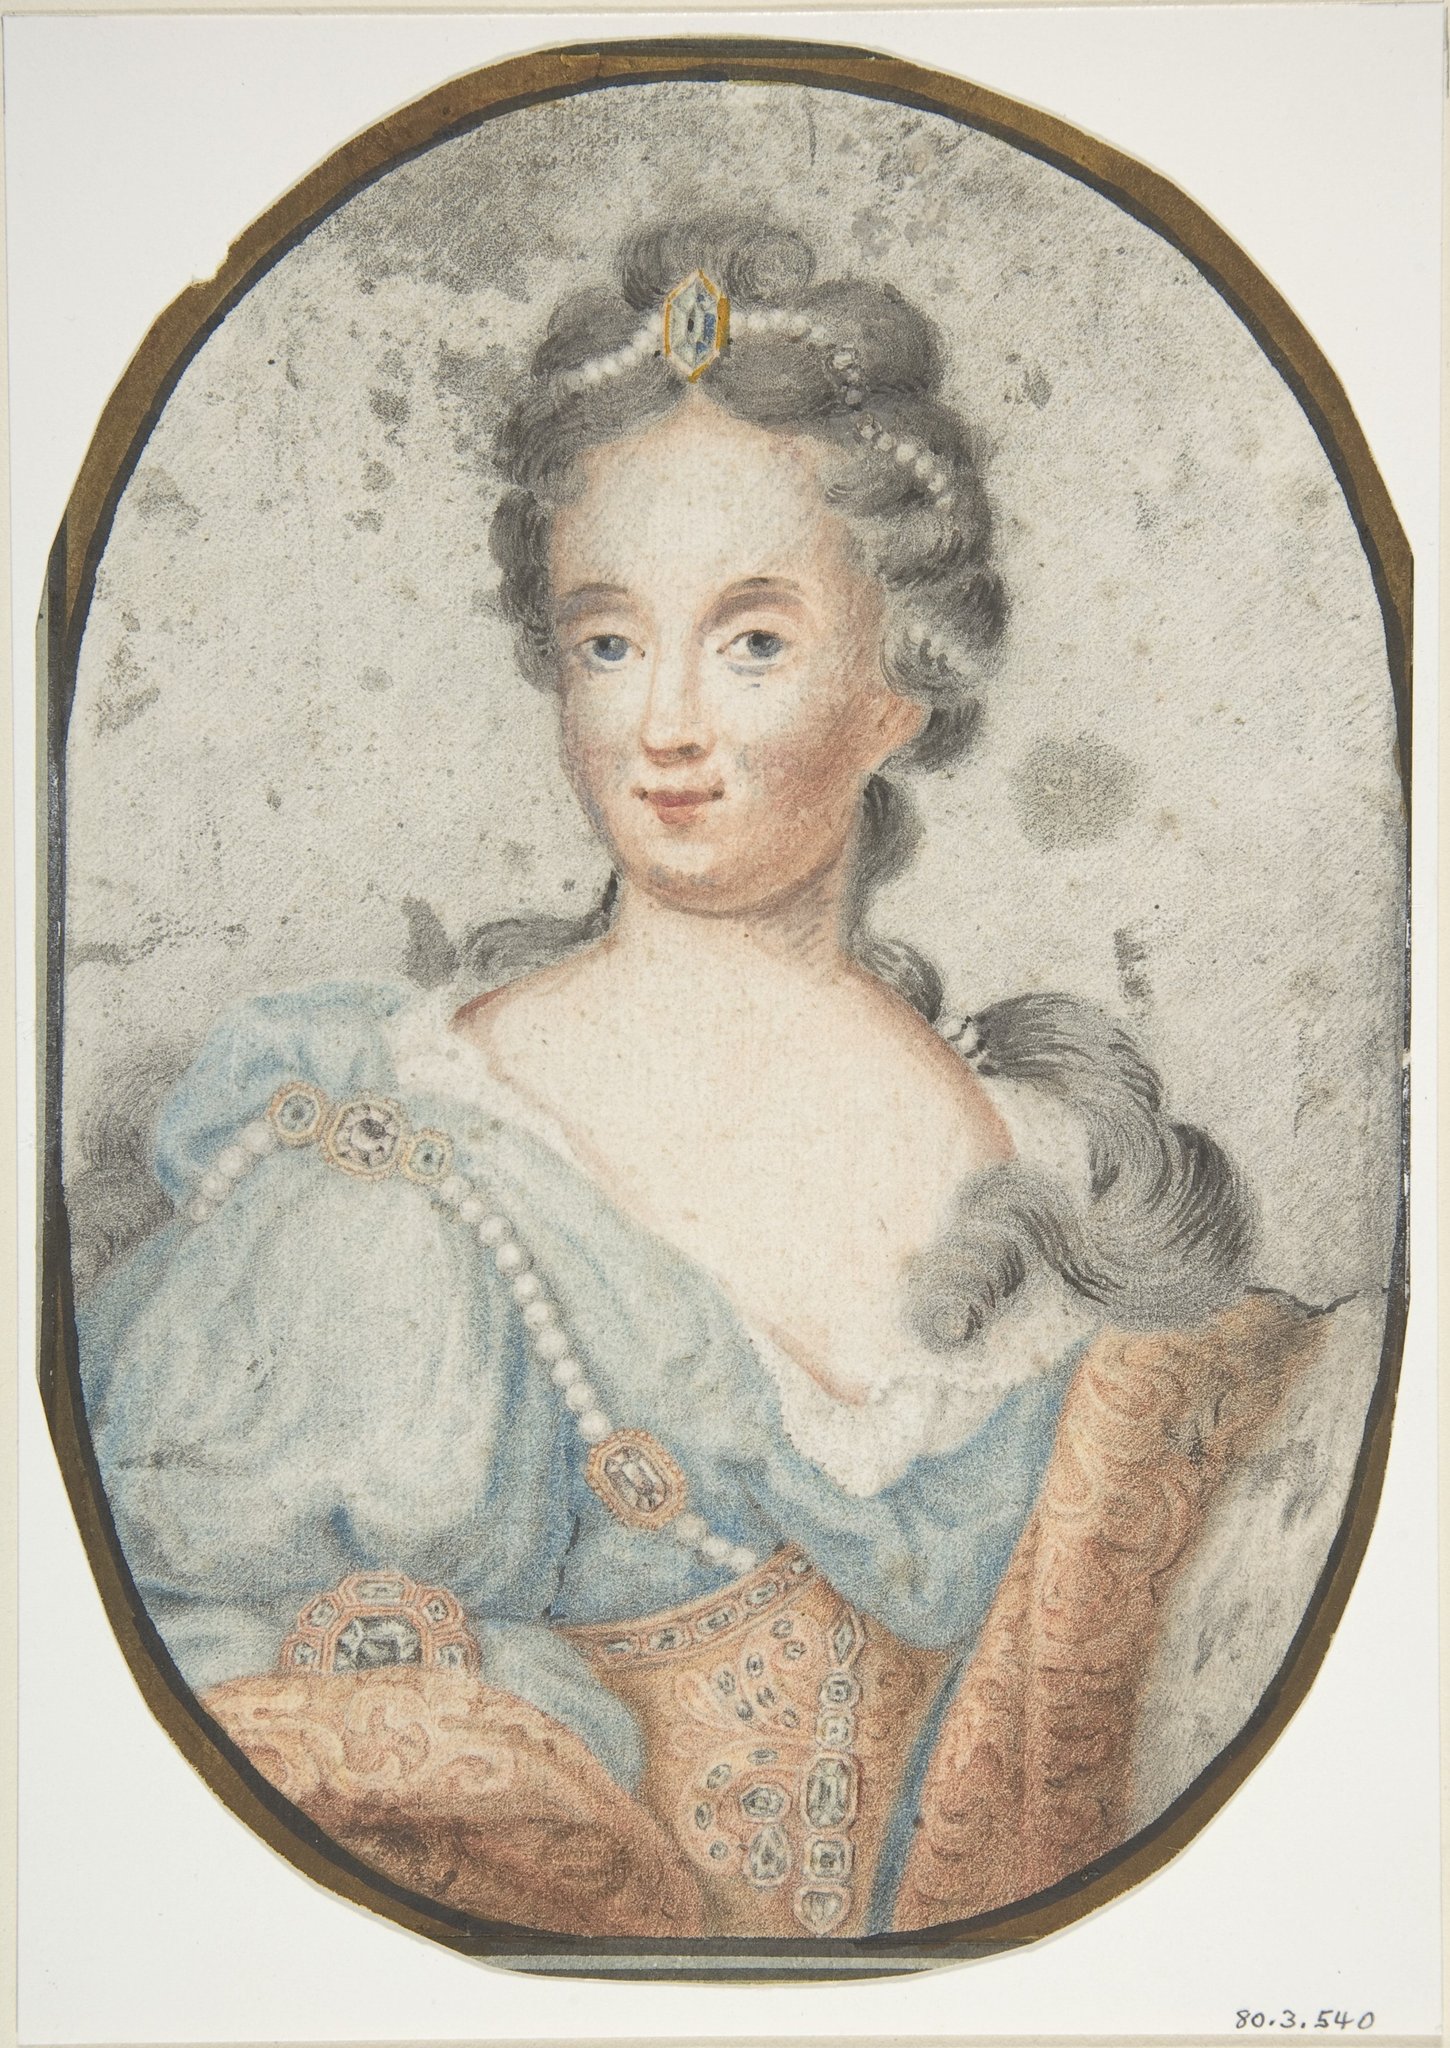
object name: drawing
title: Portrait of a Lady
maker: anonymous, german, 19th century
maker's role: artist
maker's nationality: german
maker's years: 1800-1899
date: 1801-1900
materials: pastel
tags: portraits,women